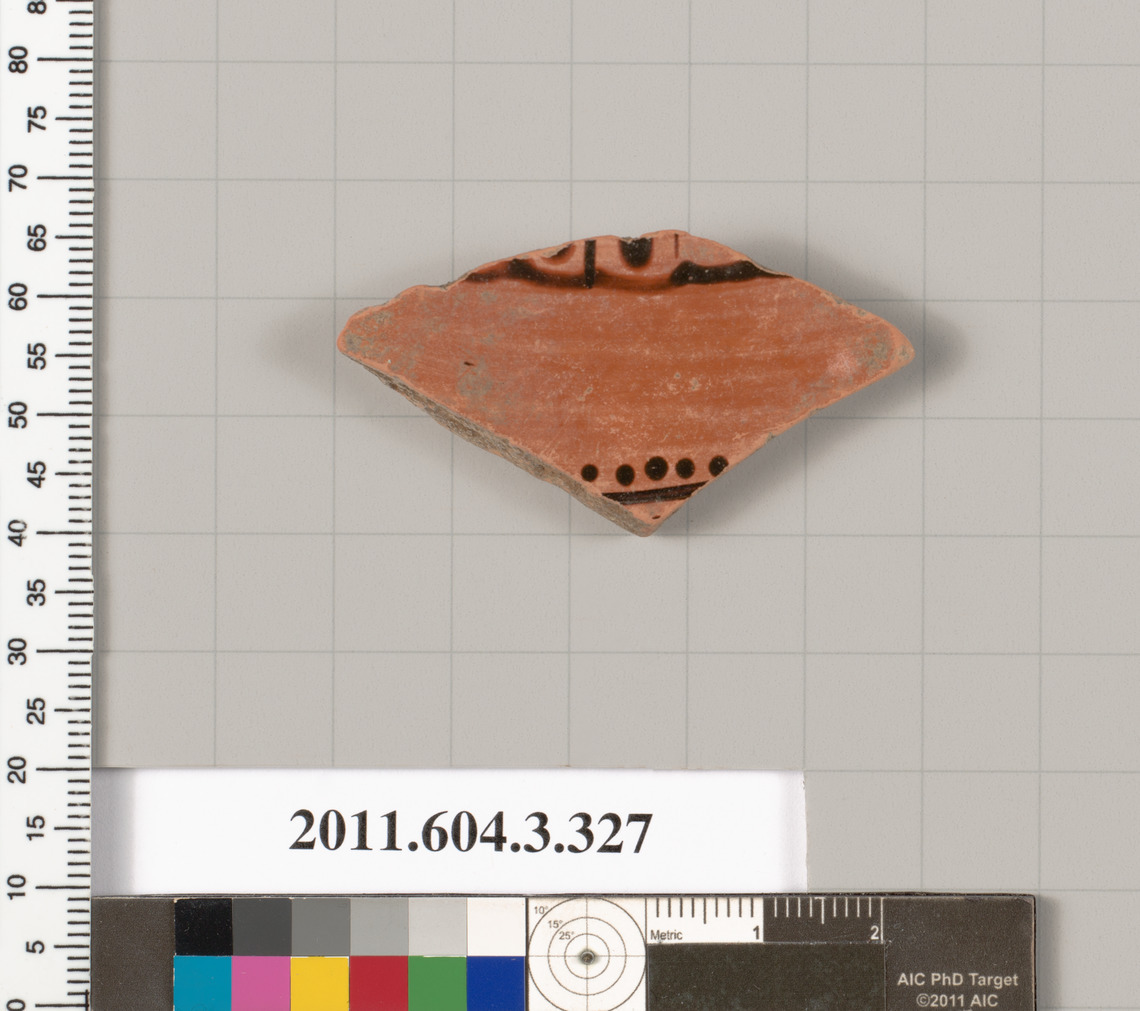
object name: neck amphora fragment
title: Terracotta fragment of a neck-amphora (jar)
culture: greek, attic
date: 525-501 BCE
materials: terracotta